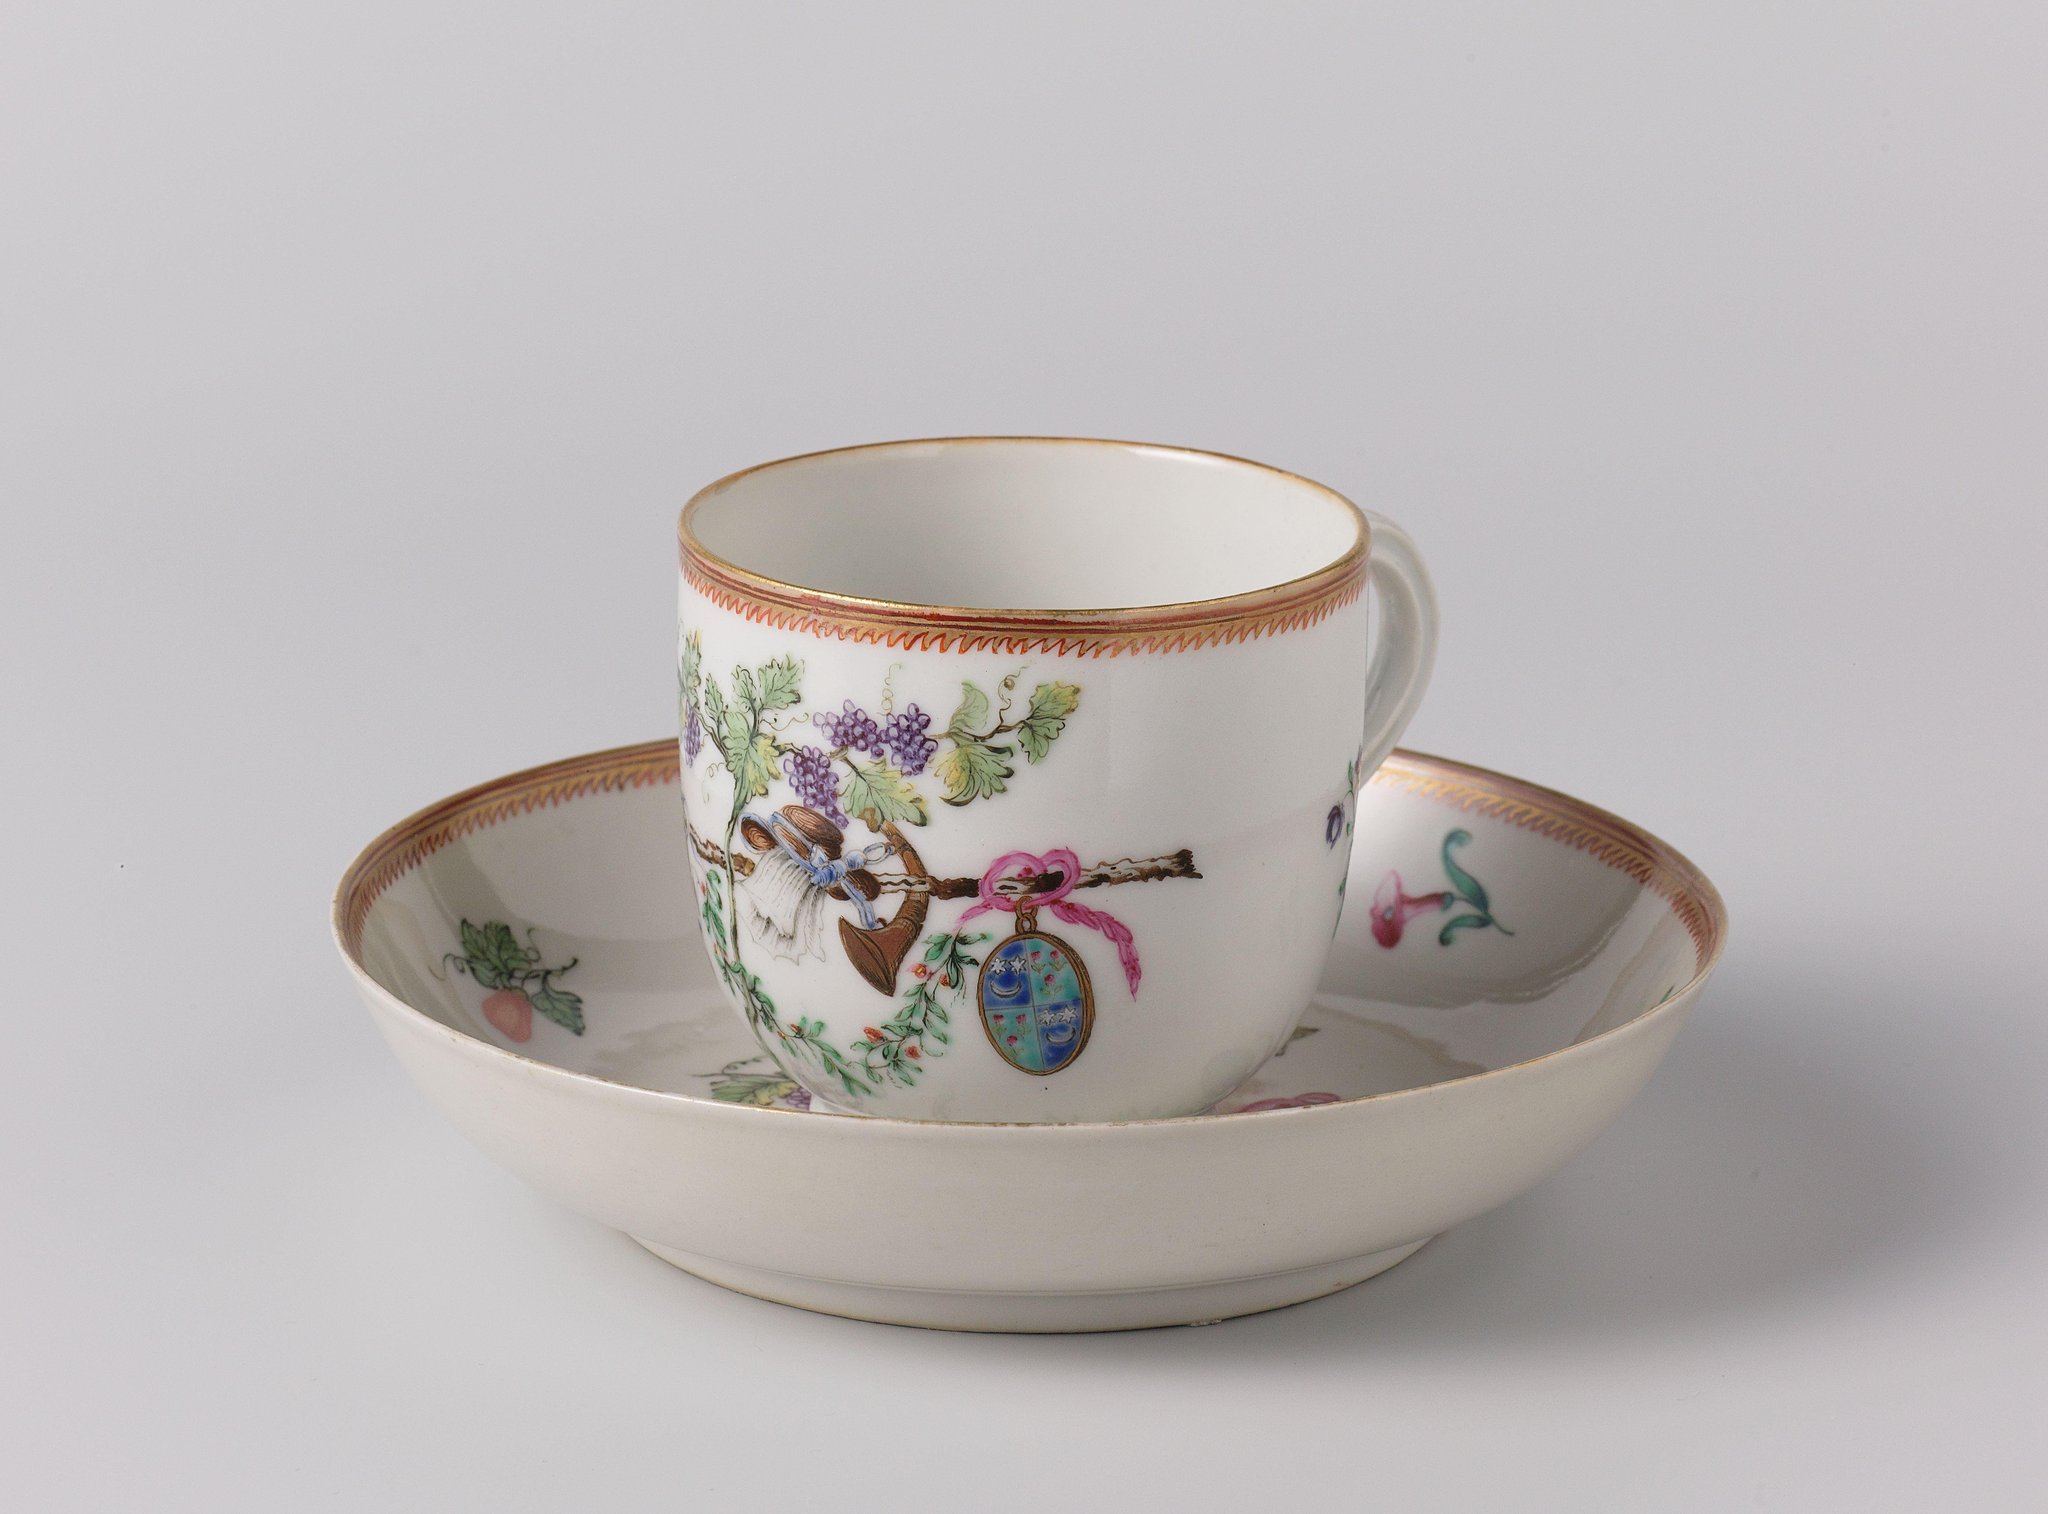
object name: cup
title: Cup with handle with the arms of the Visvliet and Sluymer families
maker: Anonymous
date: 1777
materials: glaze, gold, paint, porcelain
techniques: firing, gilding, turning, vitrification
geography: china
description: In het centrum hangen twee wapens, verbonden door een guirlande, aan bloem- en vruchtentakken. Het wapen links is van de familie Van Visvliet en is opgedeeld in twee velden met vissen en een roos. Het wapen rechts is van de familie Sluijmer en is opgedeeld in vier velden, met hemellichamen, en rode bloemen. Aan de takken zijn, behalve de wapens, een dameshoed, een blad papier en een hoorn bevestigd. De kop en schotel zijn verder versierd met strooibloemen en een rand in goud.